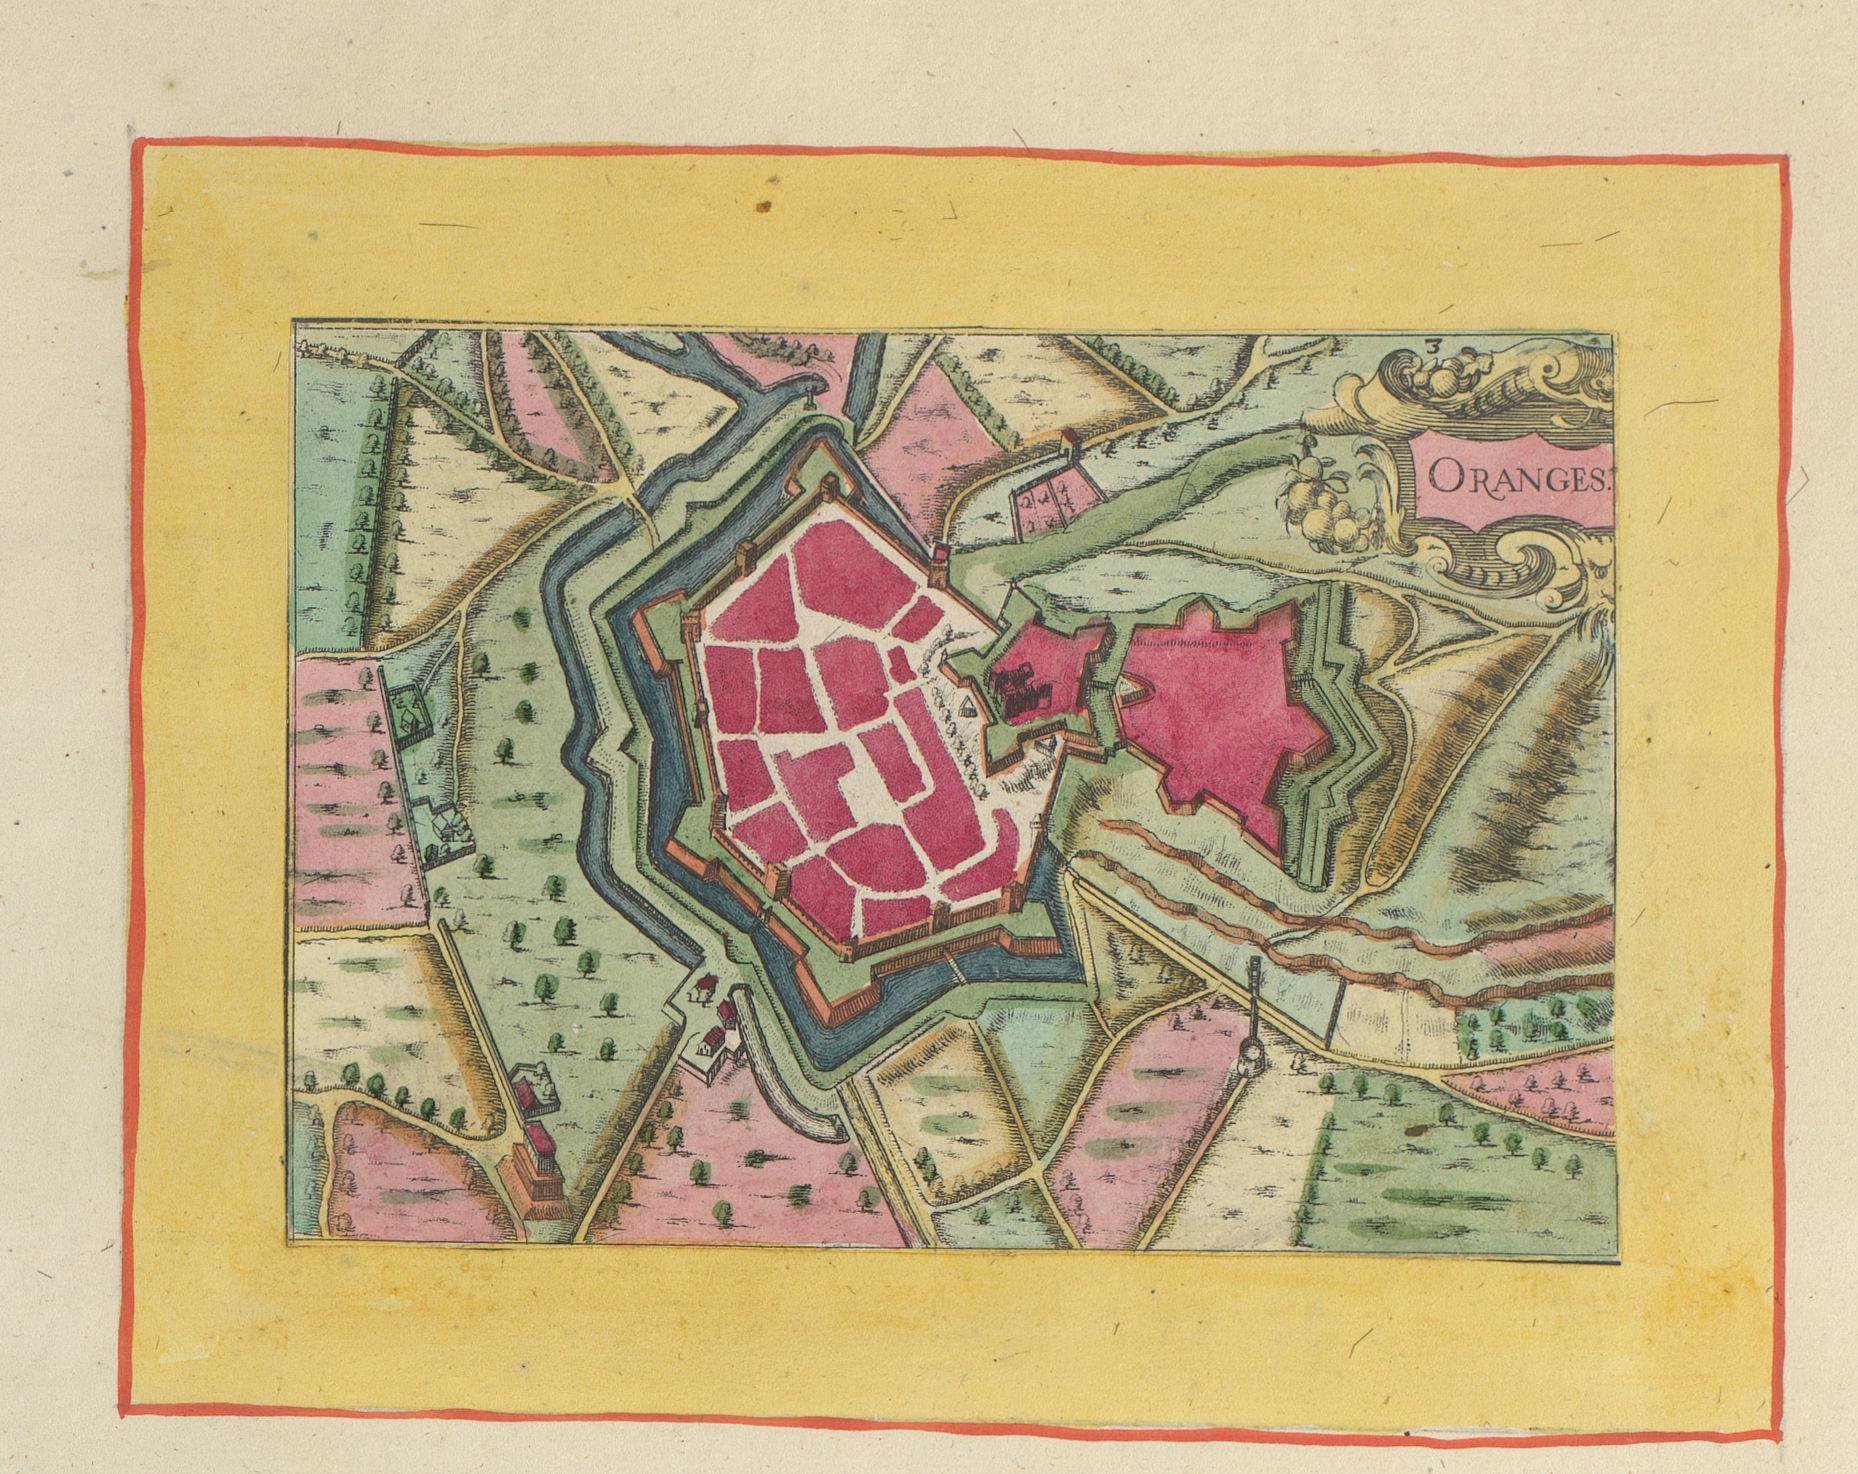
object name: print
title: Plattegrond van Orange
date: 1638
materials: paper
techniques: engraving, etching, hand coloring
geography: paris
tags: maps of cities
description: Prent uit: Tassin, Christophe. Les plans et profils de toutes les principales villes et lieux considérables de France (...). Parijs: Michel van Lochom, 1638, kaart 2 uit het deel 'Principaute d'Oranges'.